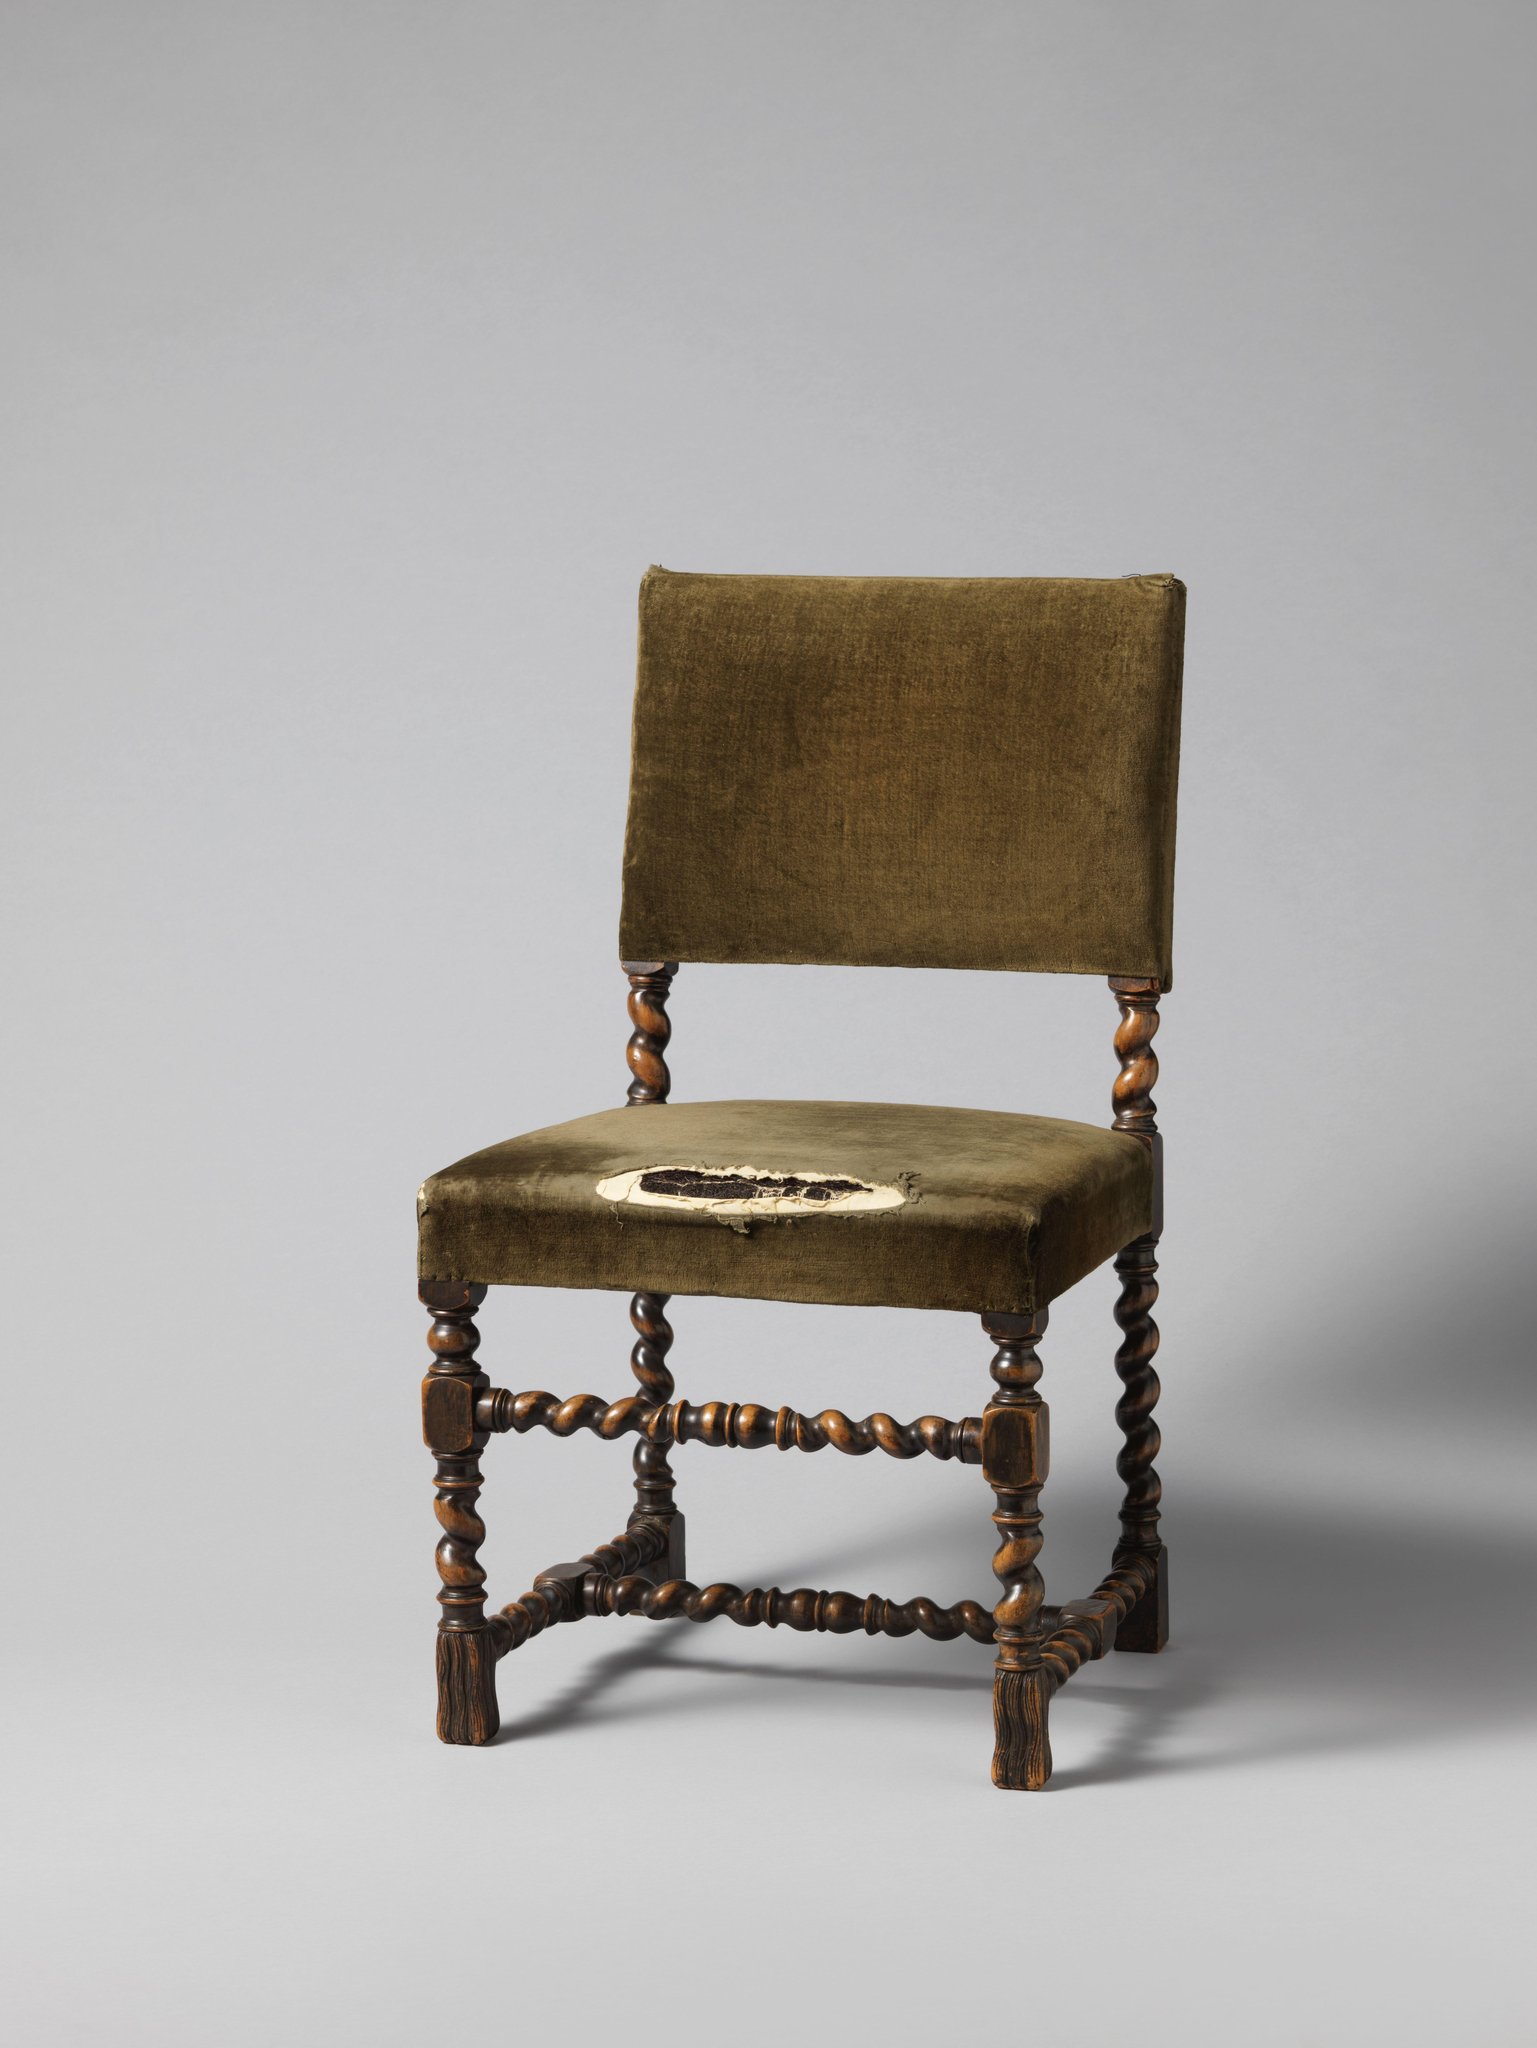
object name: furniture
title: Stoel in neo renaissance-stijl met geslingerde onderdelen en met beklede zitting.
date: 1880-1920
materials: hair, textile, wood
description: Stoel behorend tot een set van drie stoelen en een armstoel van notenhout met een beklede zitting. De geslingerde poten zijn verbonden door een geslingerd H-vormig kruis en een eveneens geslingerde voorsport. Het beklede rugraam rust op gelede stutten. De leunstoel heeft geslingerde armleggerstutten en armleggers. Zie: BK-1959-116-a/d.